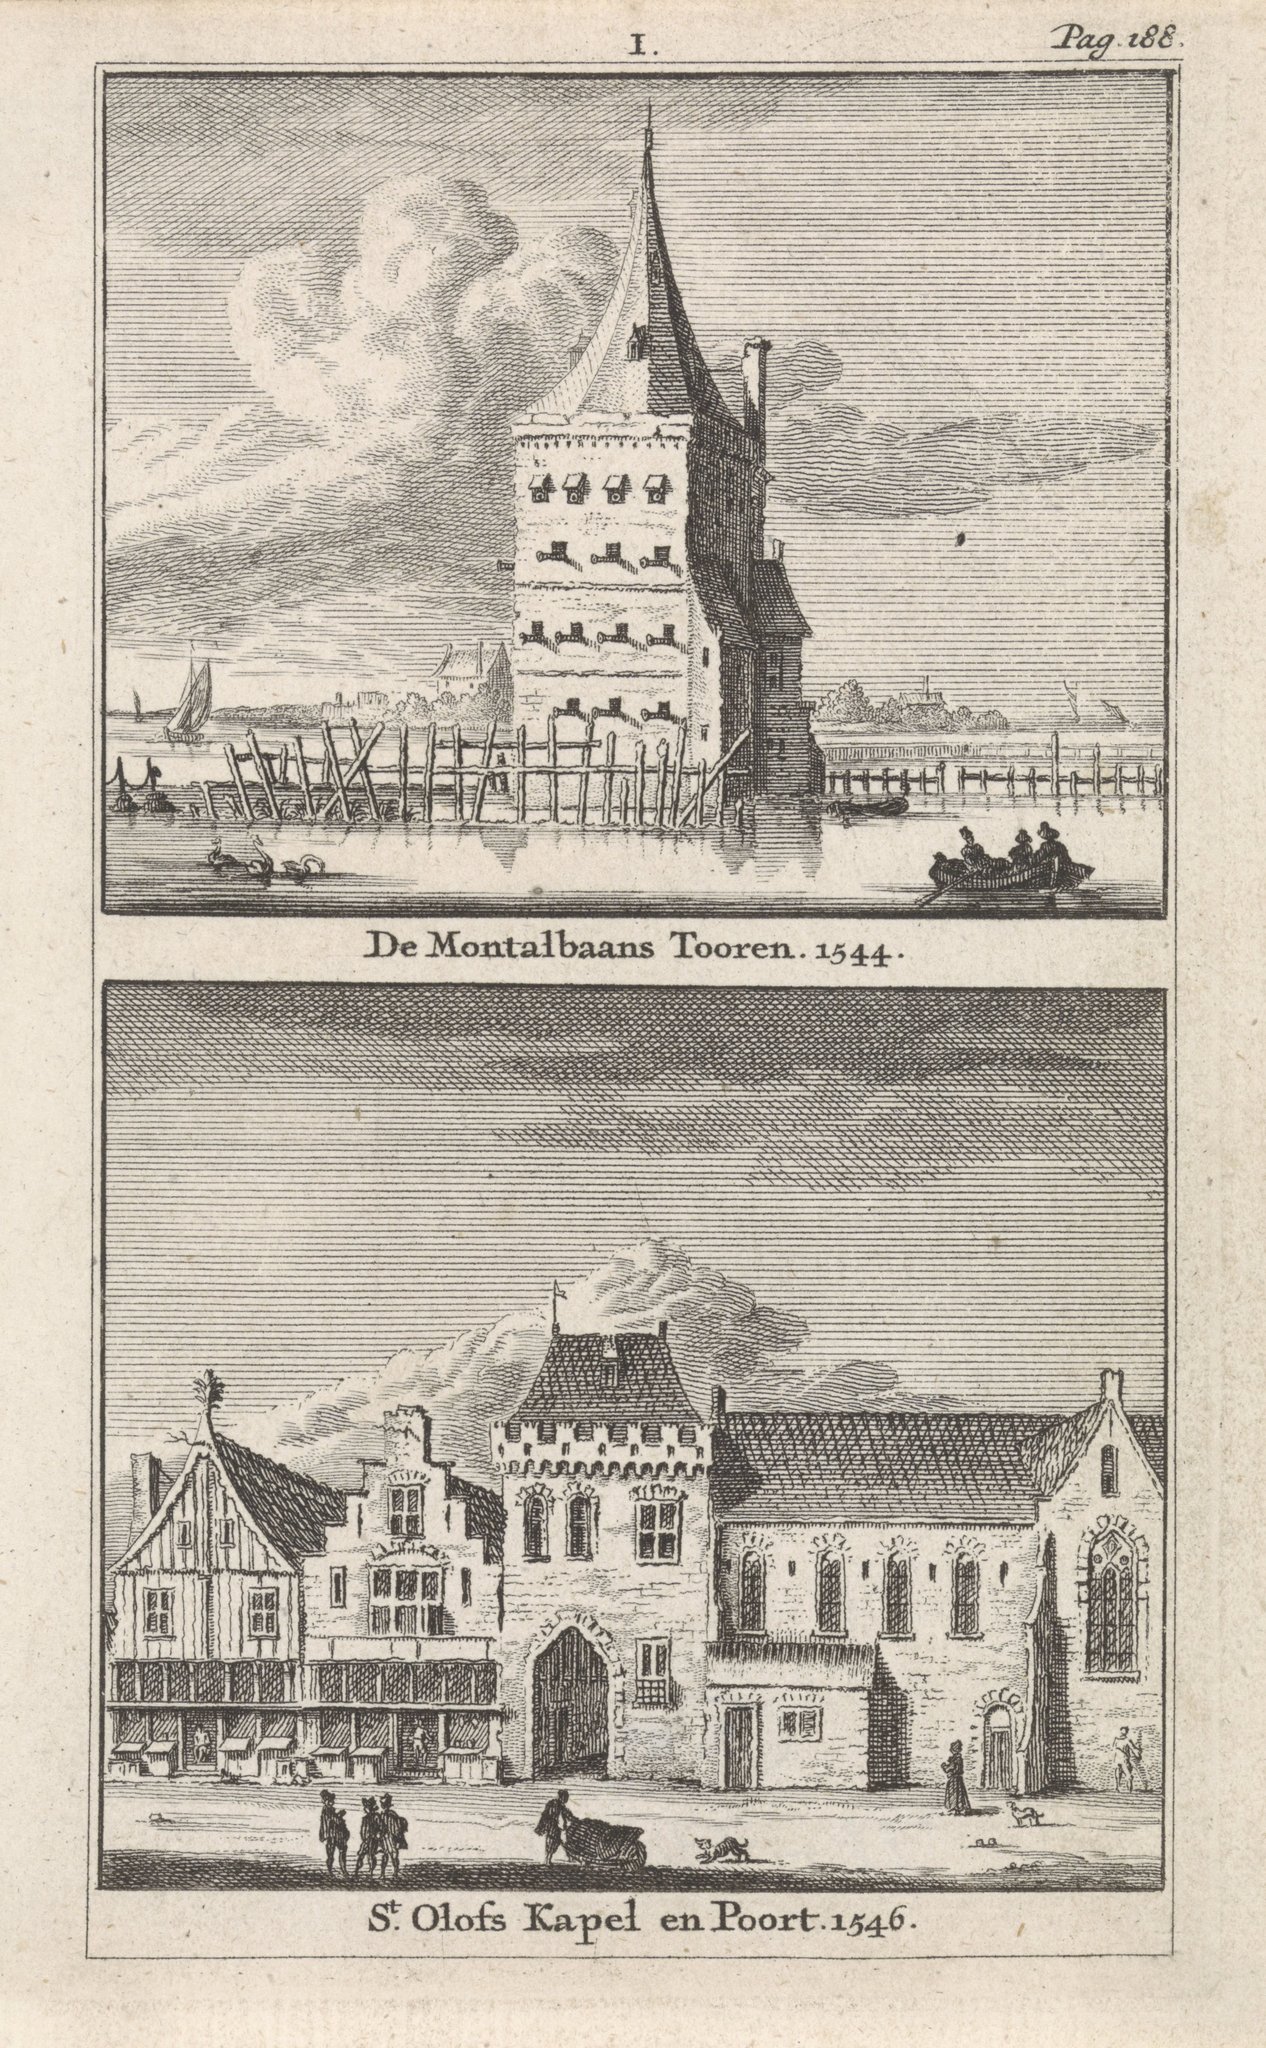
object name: print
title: Gezicht op de Montelbaanstoren en de Sint-Olofskapel te Amsterdam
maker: jan goeree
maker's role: draughtsman, print maker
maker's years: 1670-1731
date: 1723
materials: paper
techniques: engraving, etching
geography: amsterdam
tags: towers ~ fortified city, city-gate (+ city(-scape) with figures, staffage)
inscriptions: collector's mark: Lugt 2228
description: Twee voorstellingen. Boven: de Montelbaanstoren van Amsterdam rond 1544. Onder: de Sint-Olofskapel en de Sint-Olofspoort van Amsterdam rond 1546. Elke voorstelling heeft een Nederlands onderschrift. Rechts bovenaan het paginanummer 188.